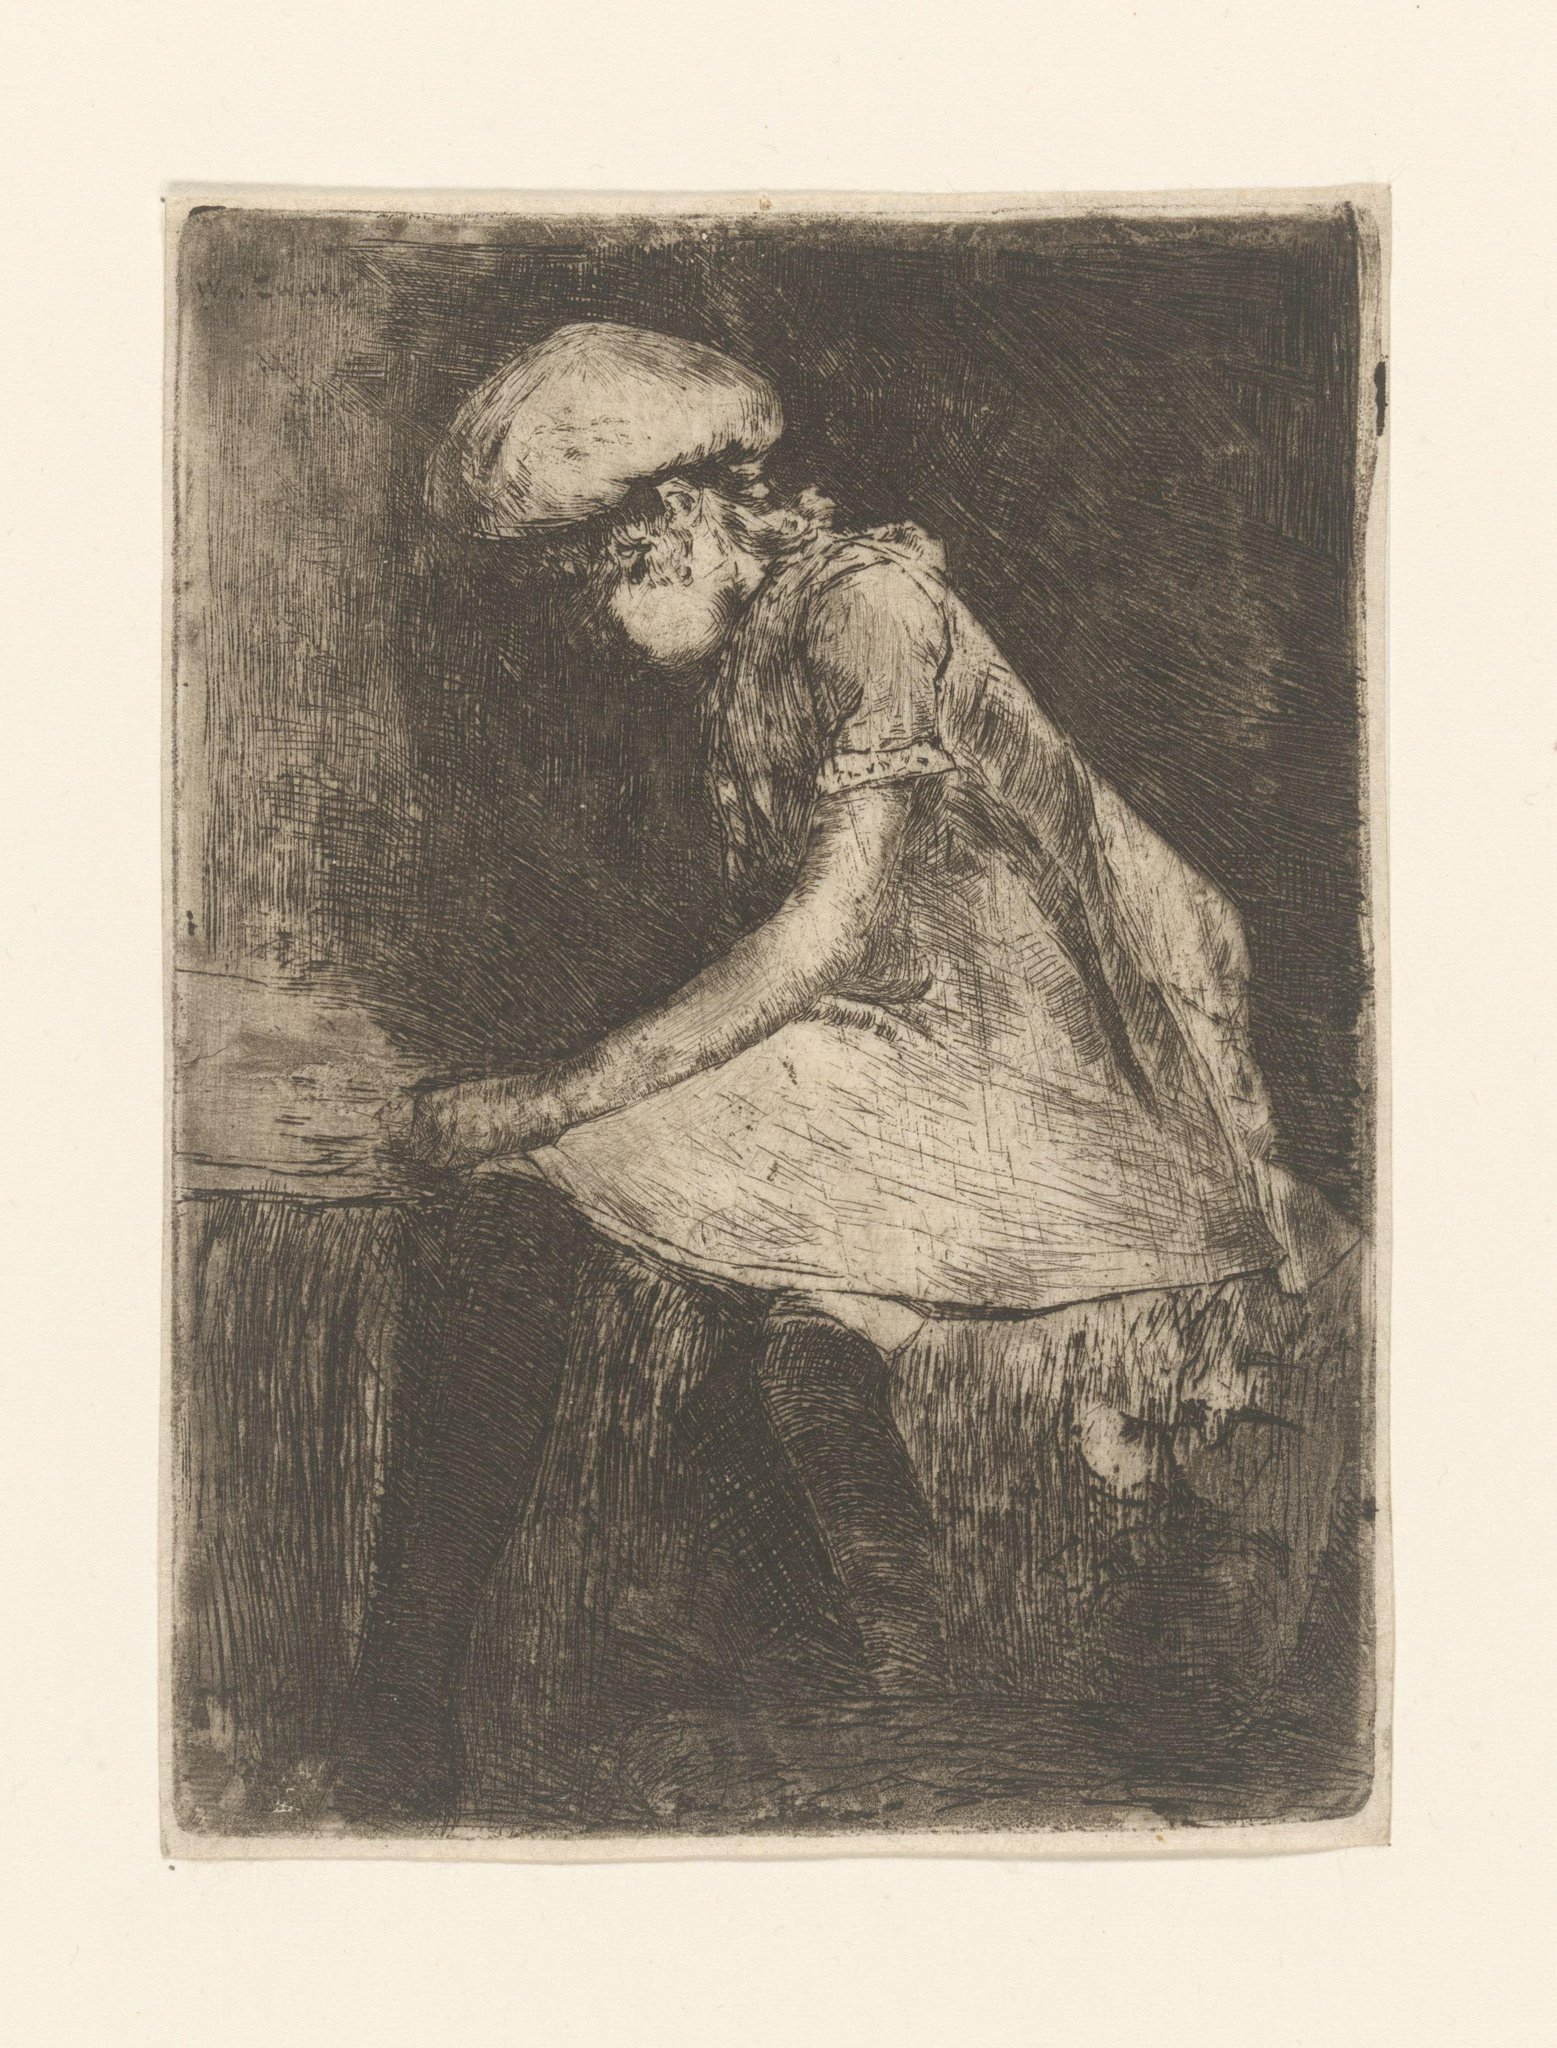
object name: print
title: Lezend meisje (en profil)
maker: willem de zwart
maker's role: draughtsman, painter, print maker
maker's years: 1862-1931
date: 1886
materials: paper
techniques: drypoint, etching, intaglio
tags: reading, girl (child between toddler and youth)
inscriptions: collector's mark: Lugt 2228